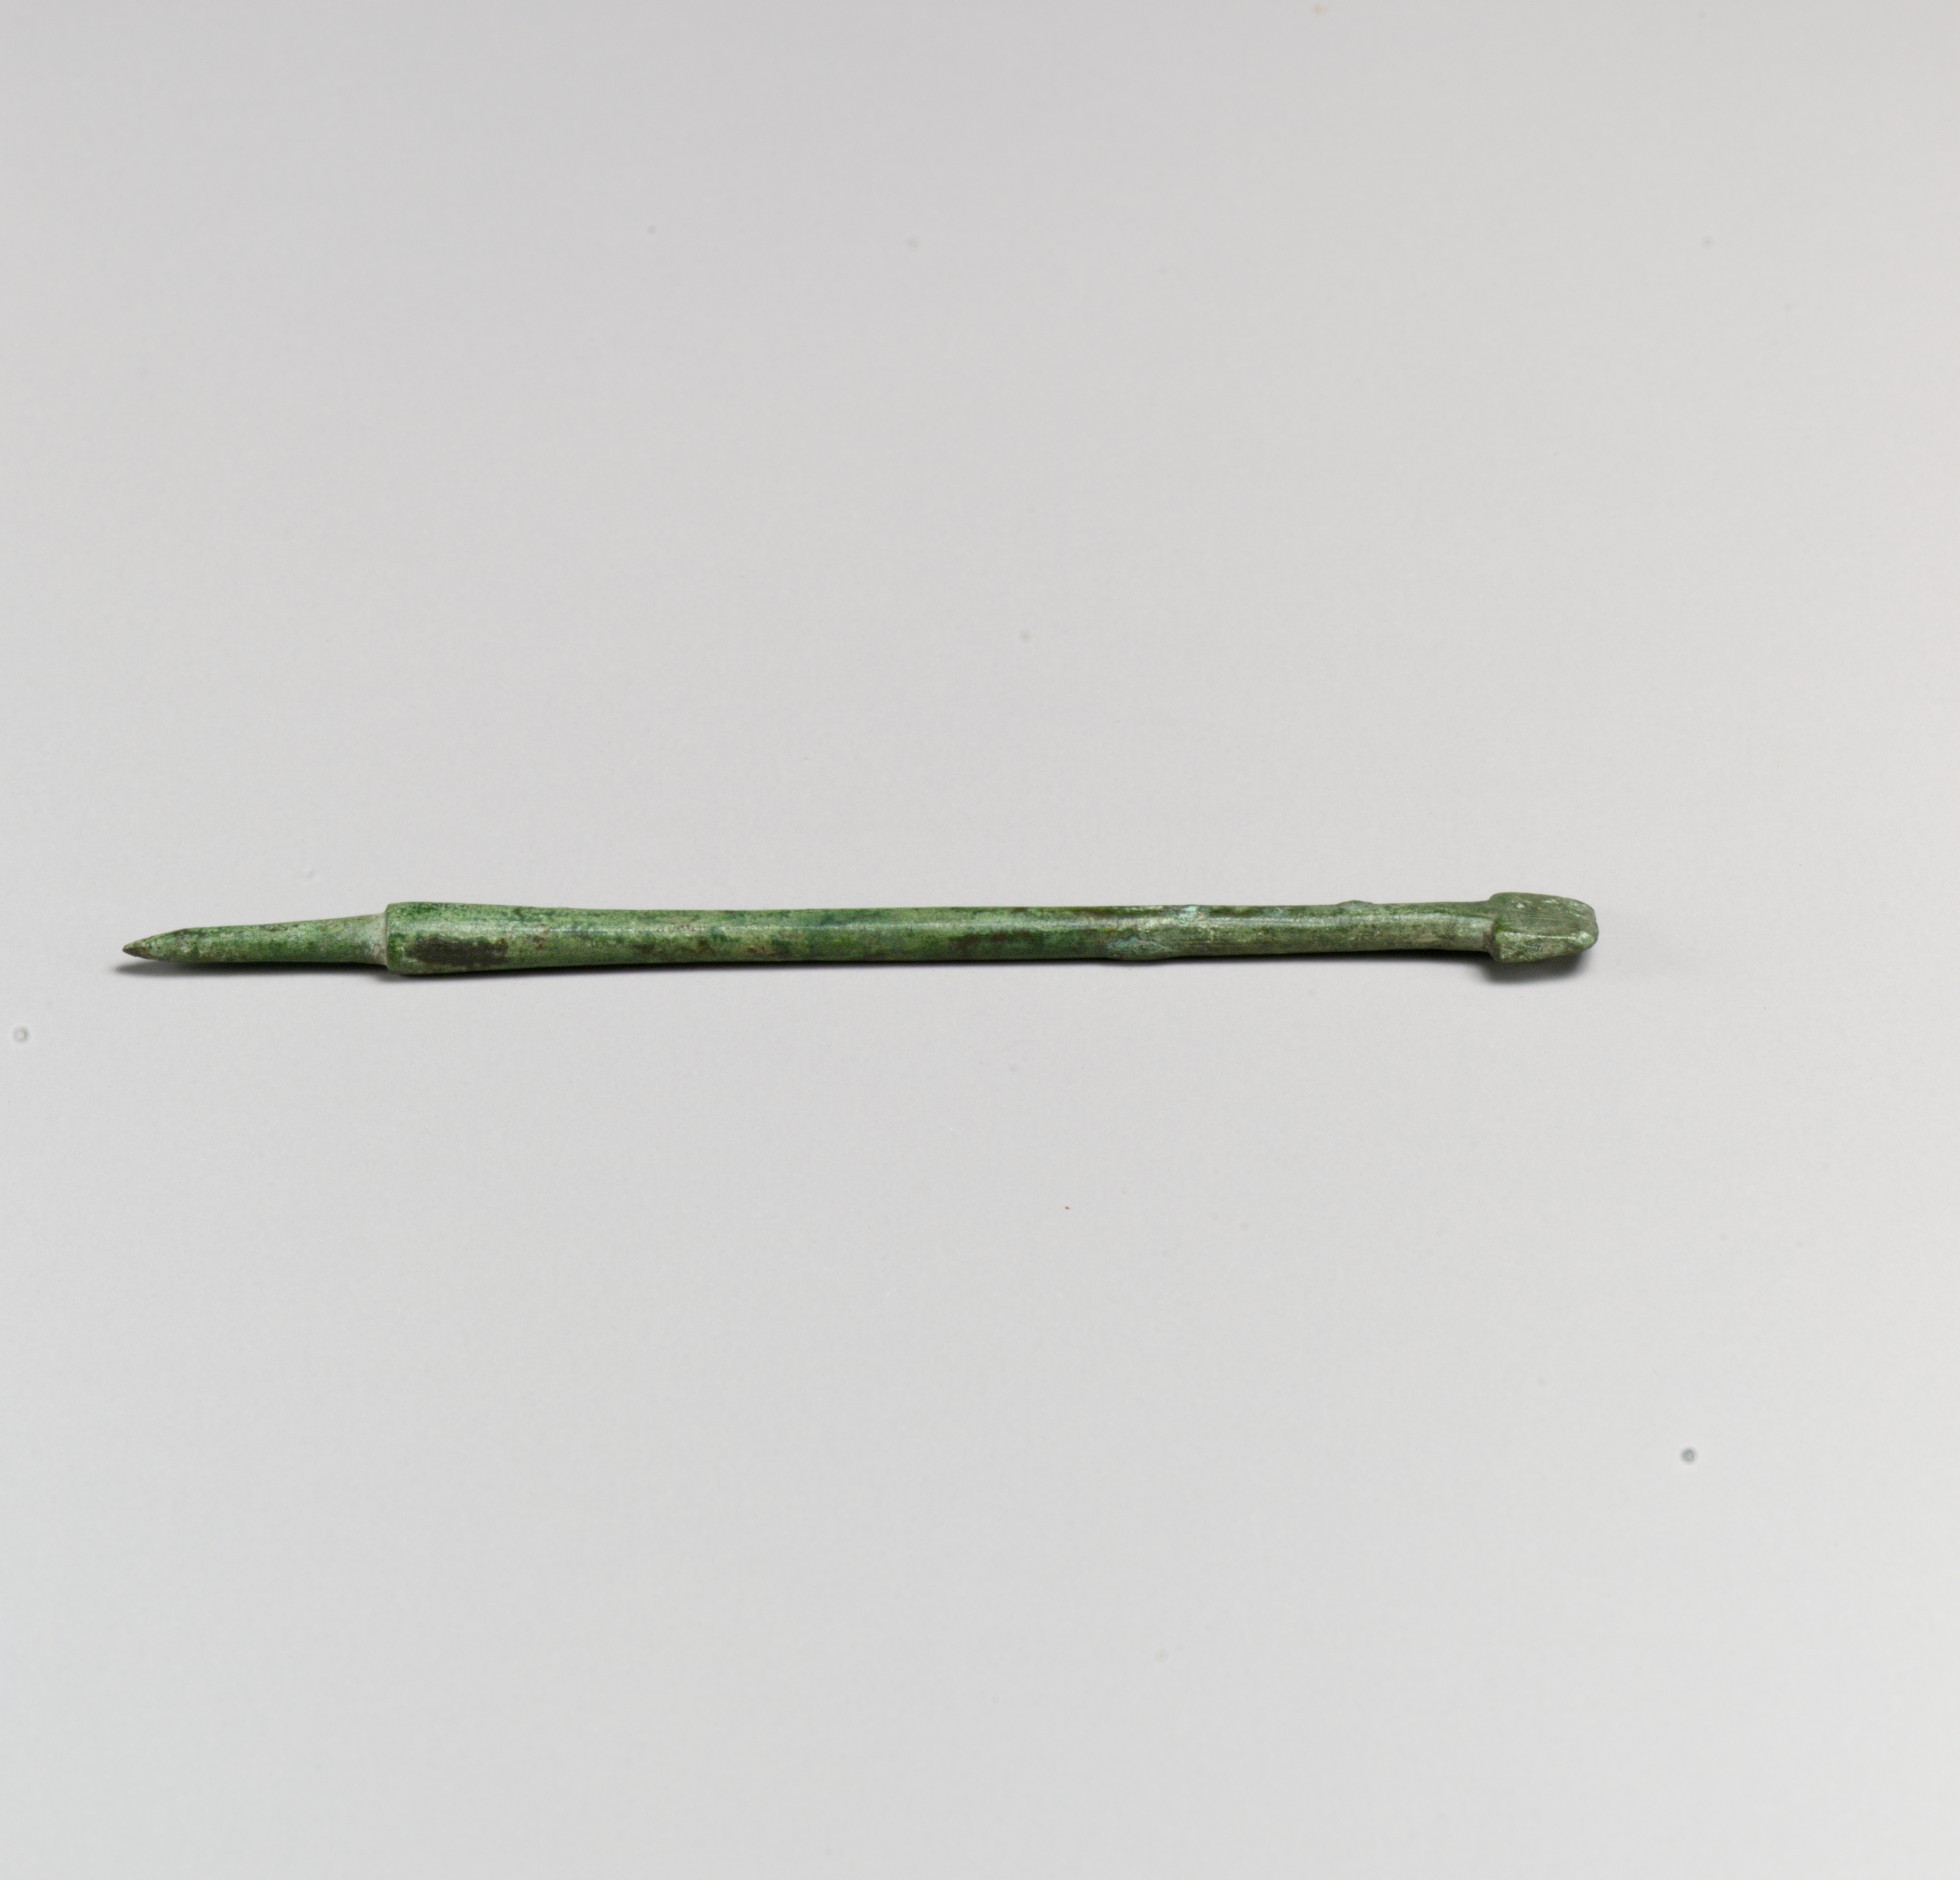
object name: stylus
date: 7000 BCE-330 CE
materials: bone, bronze